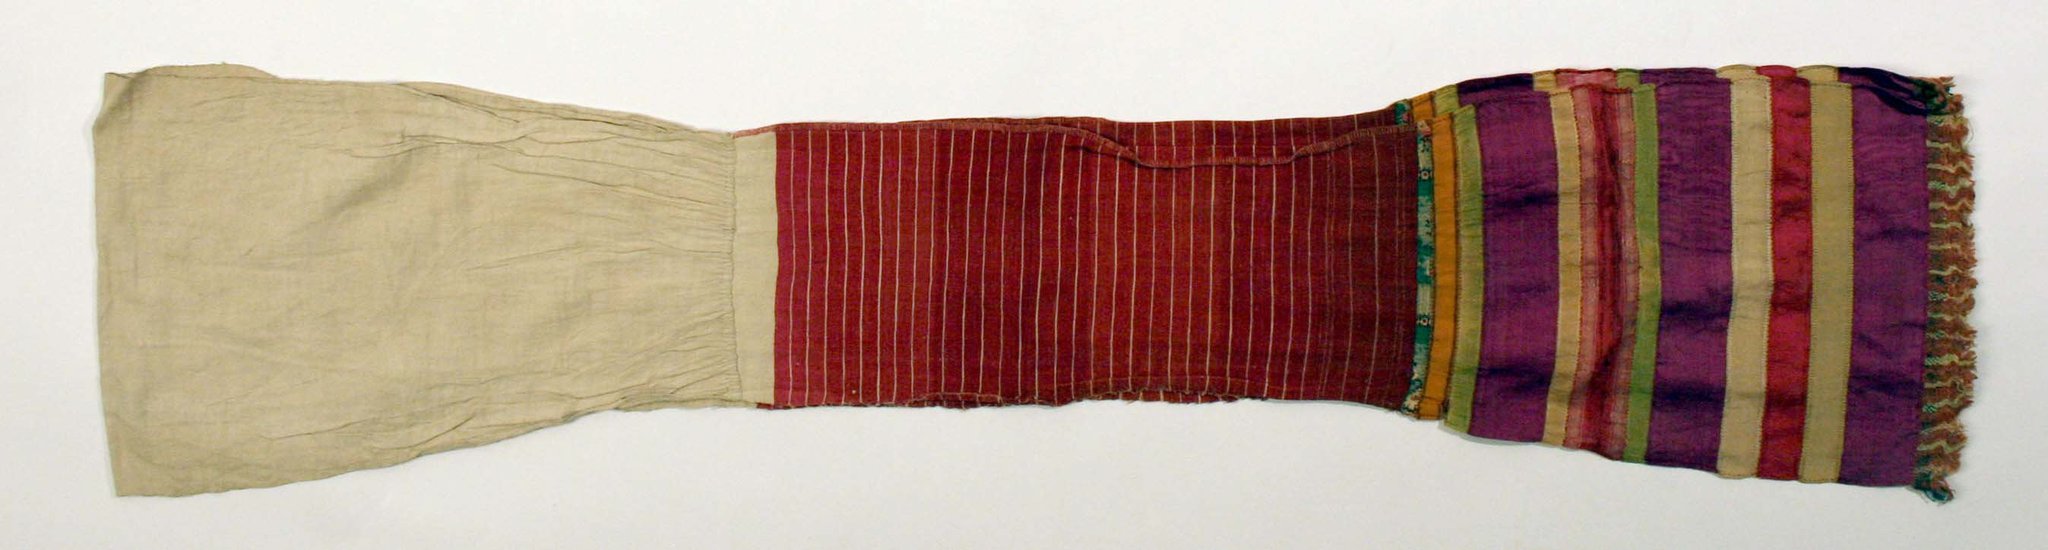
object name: headscarf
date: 1801-1900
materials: cotton, silk